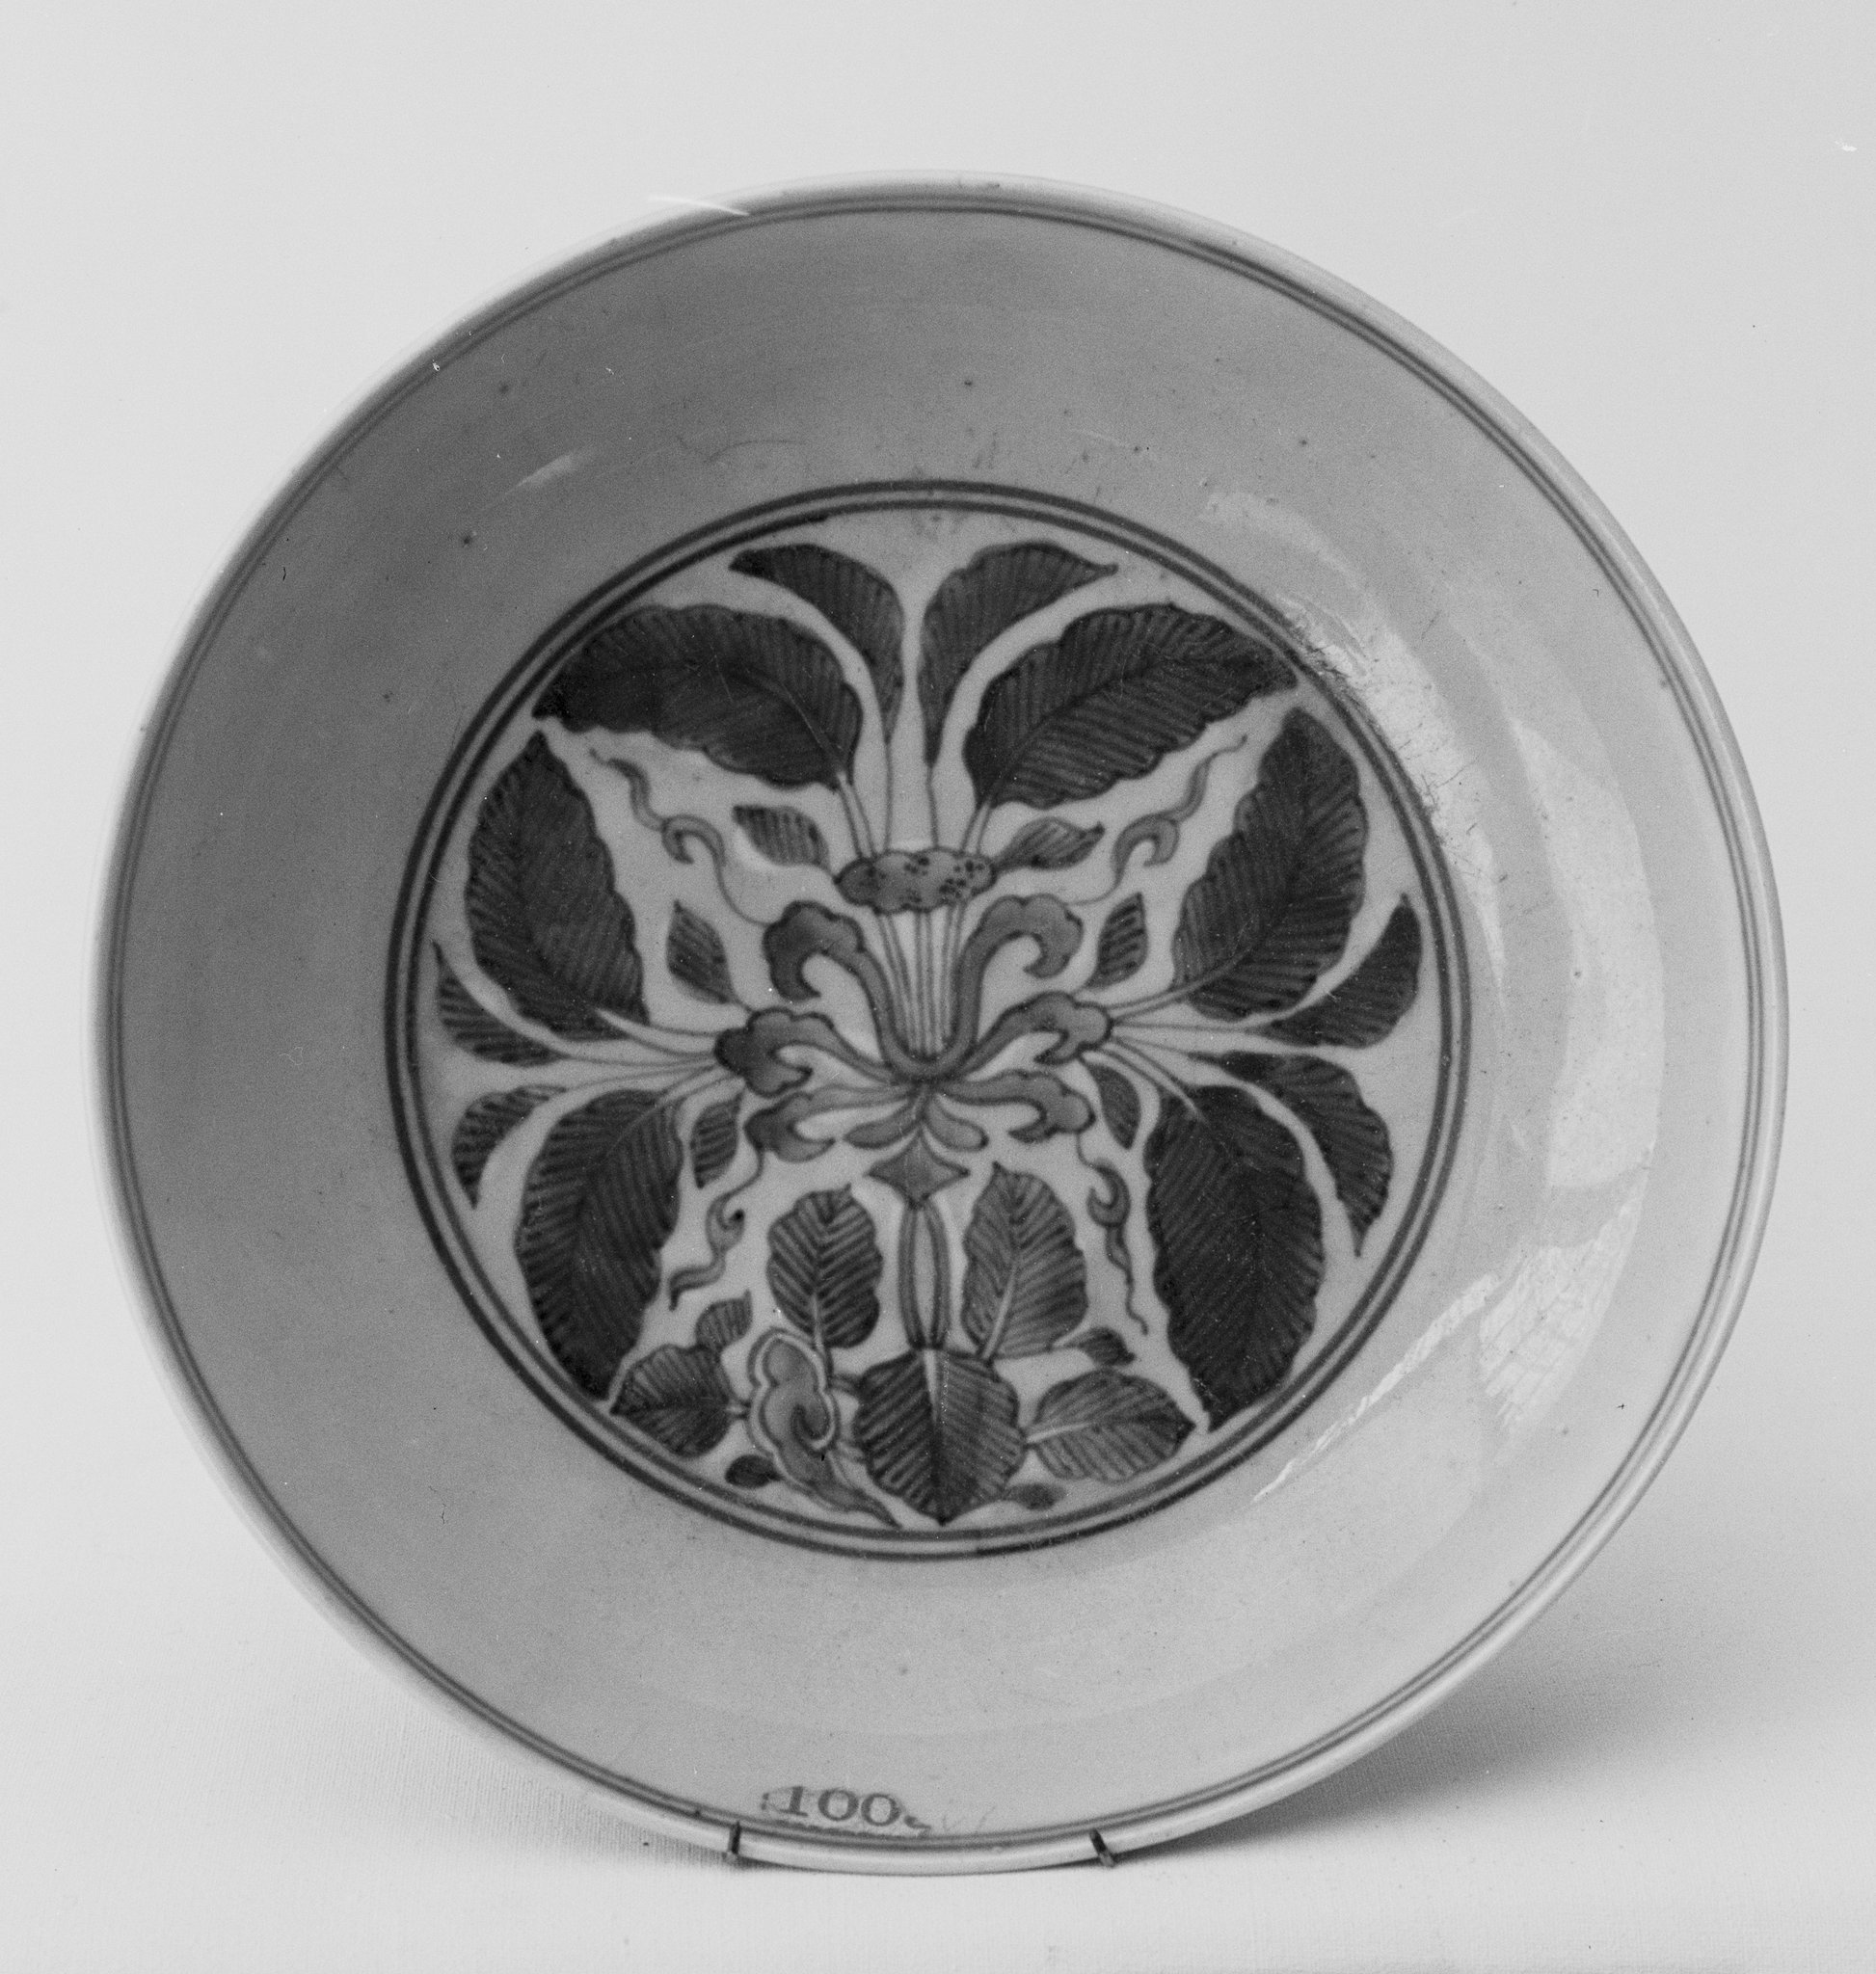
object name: dish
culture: chinese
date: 1701-1800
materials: enamel, porcelain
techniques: overglaze, painting, underglaze